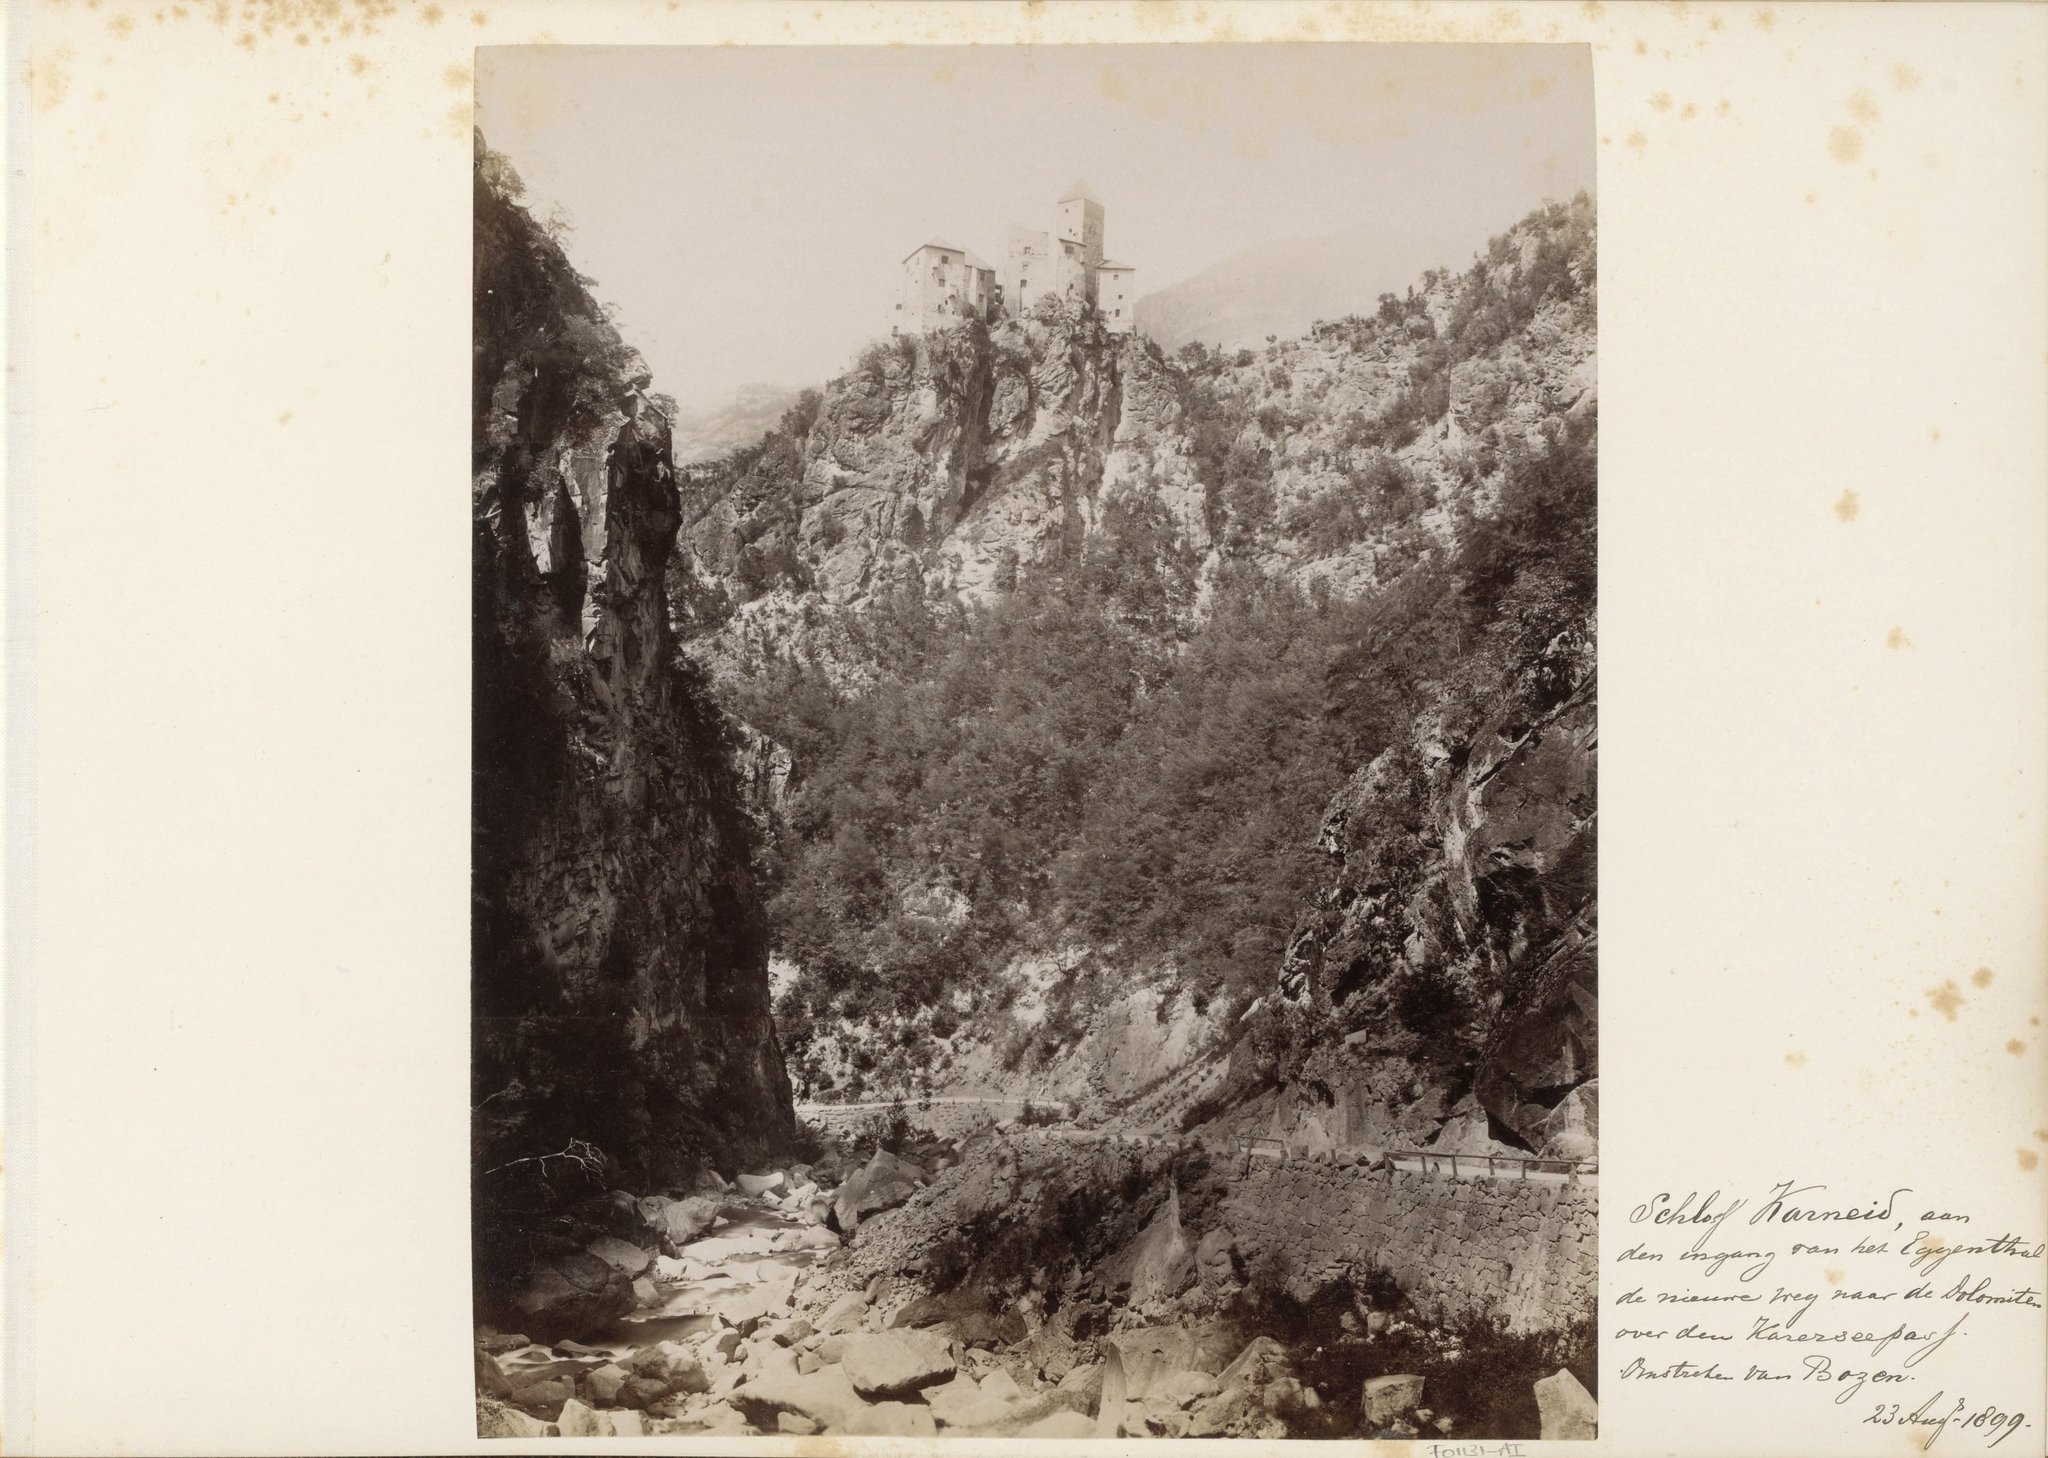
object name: photograph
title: Bergkloof en weg in het Eggental met op de rotsen kasteel Karneid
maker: Anonymous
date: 1880-1899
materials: paper, photographic support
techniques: albumen print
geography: tirol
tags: castle, ravine, chasm, abyss, canyon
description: Onderdeel van Reisalbum met bezienswaardigheden in Duitsland, Oostenrijk, Zwitserland, Luxemburg en België.